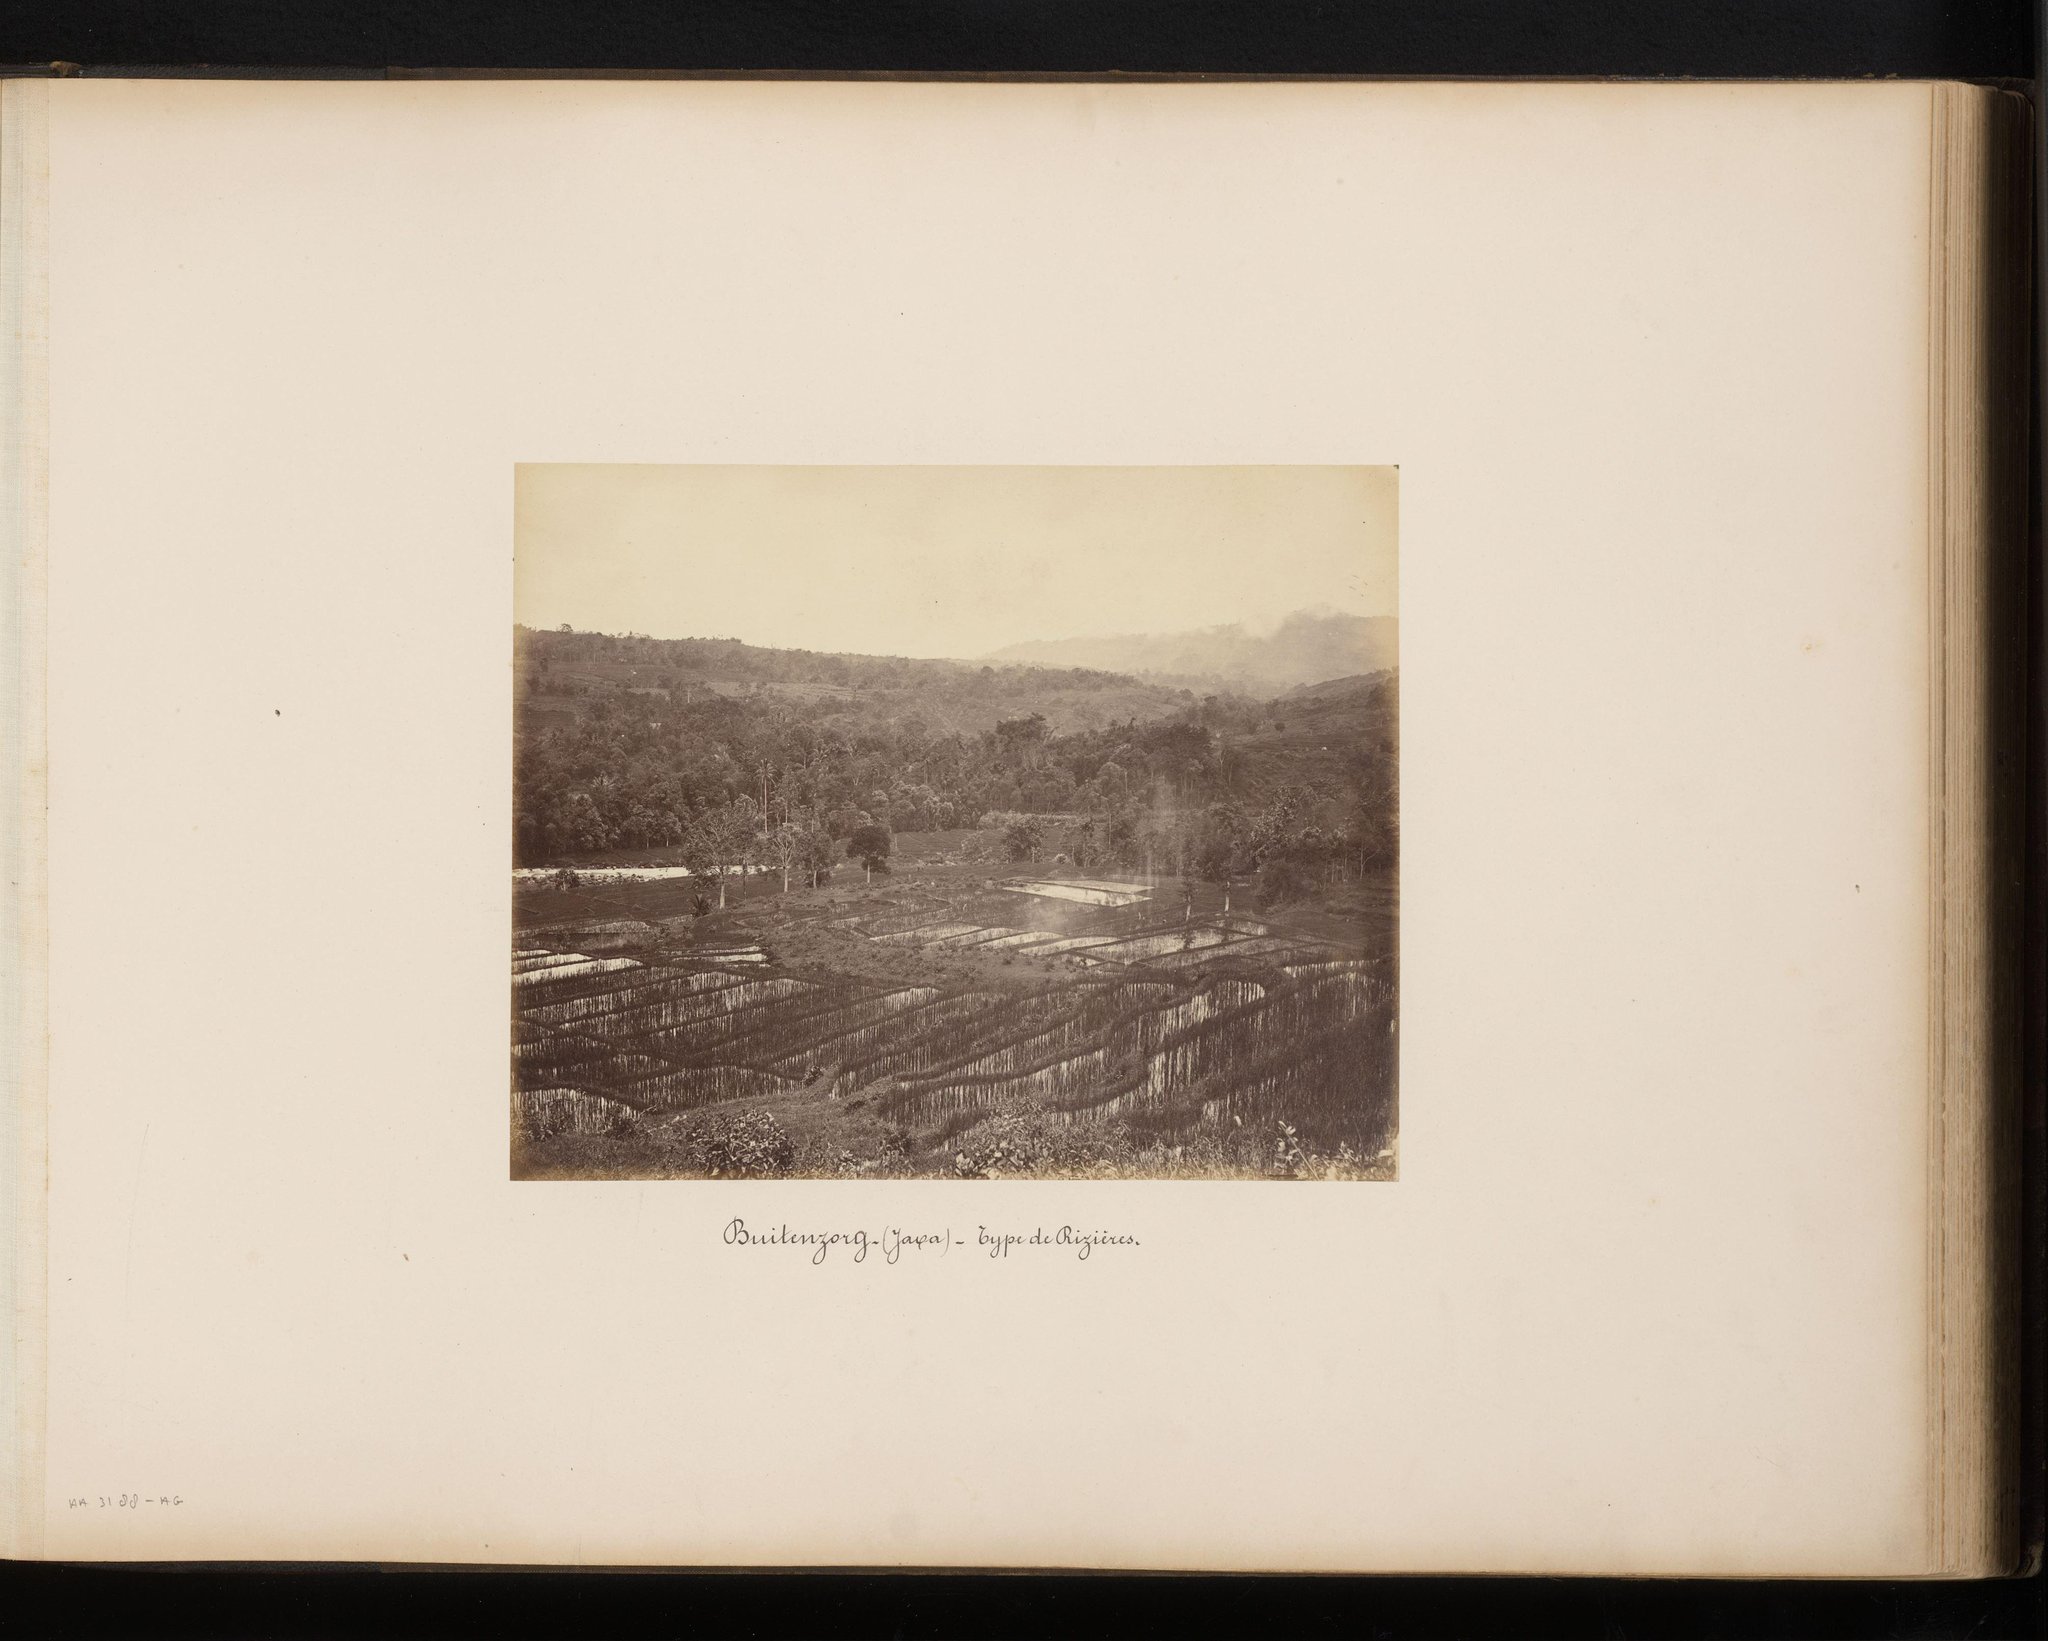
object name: photograph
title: Gezicht op rijstvelden in Buitenzorg op Java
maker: Anonymous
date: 1880-1883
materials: photographic support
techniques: albumen print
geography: buitenzorg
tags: sawahs, rice paddies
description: Onderdeel van Reisalbum met opnames van bezienswaardigheden in Egypte, Nederlands-Indië, Singapore en Ceylon.